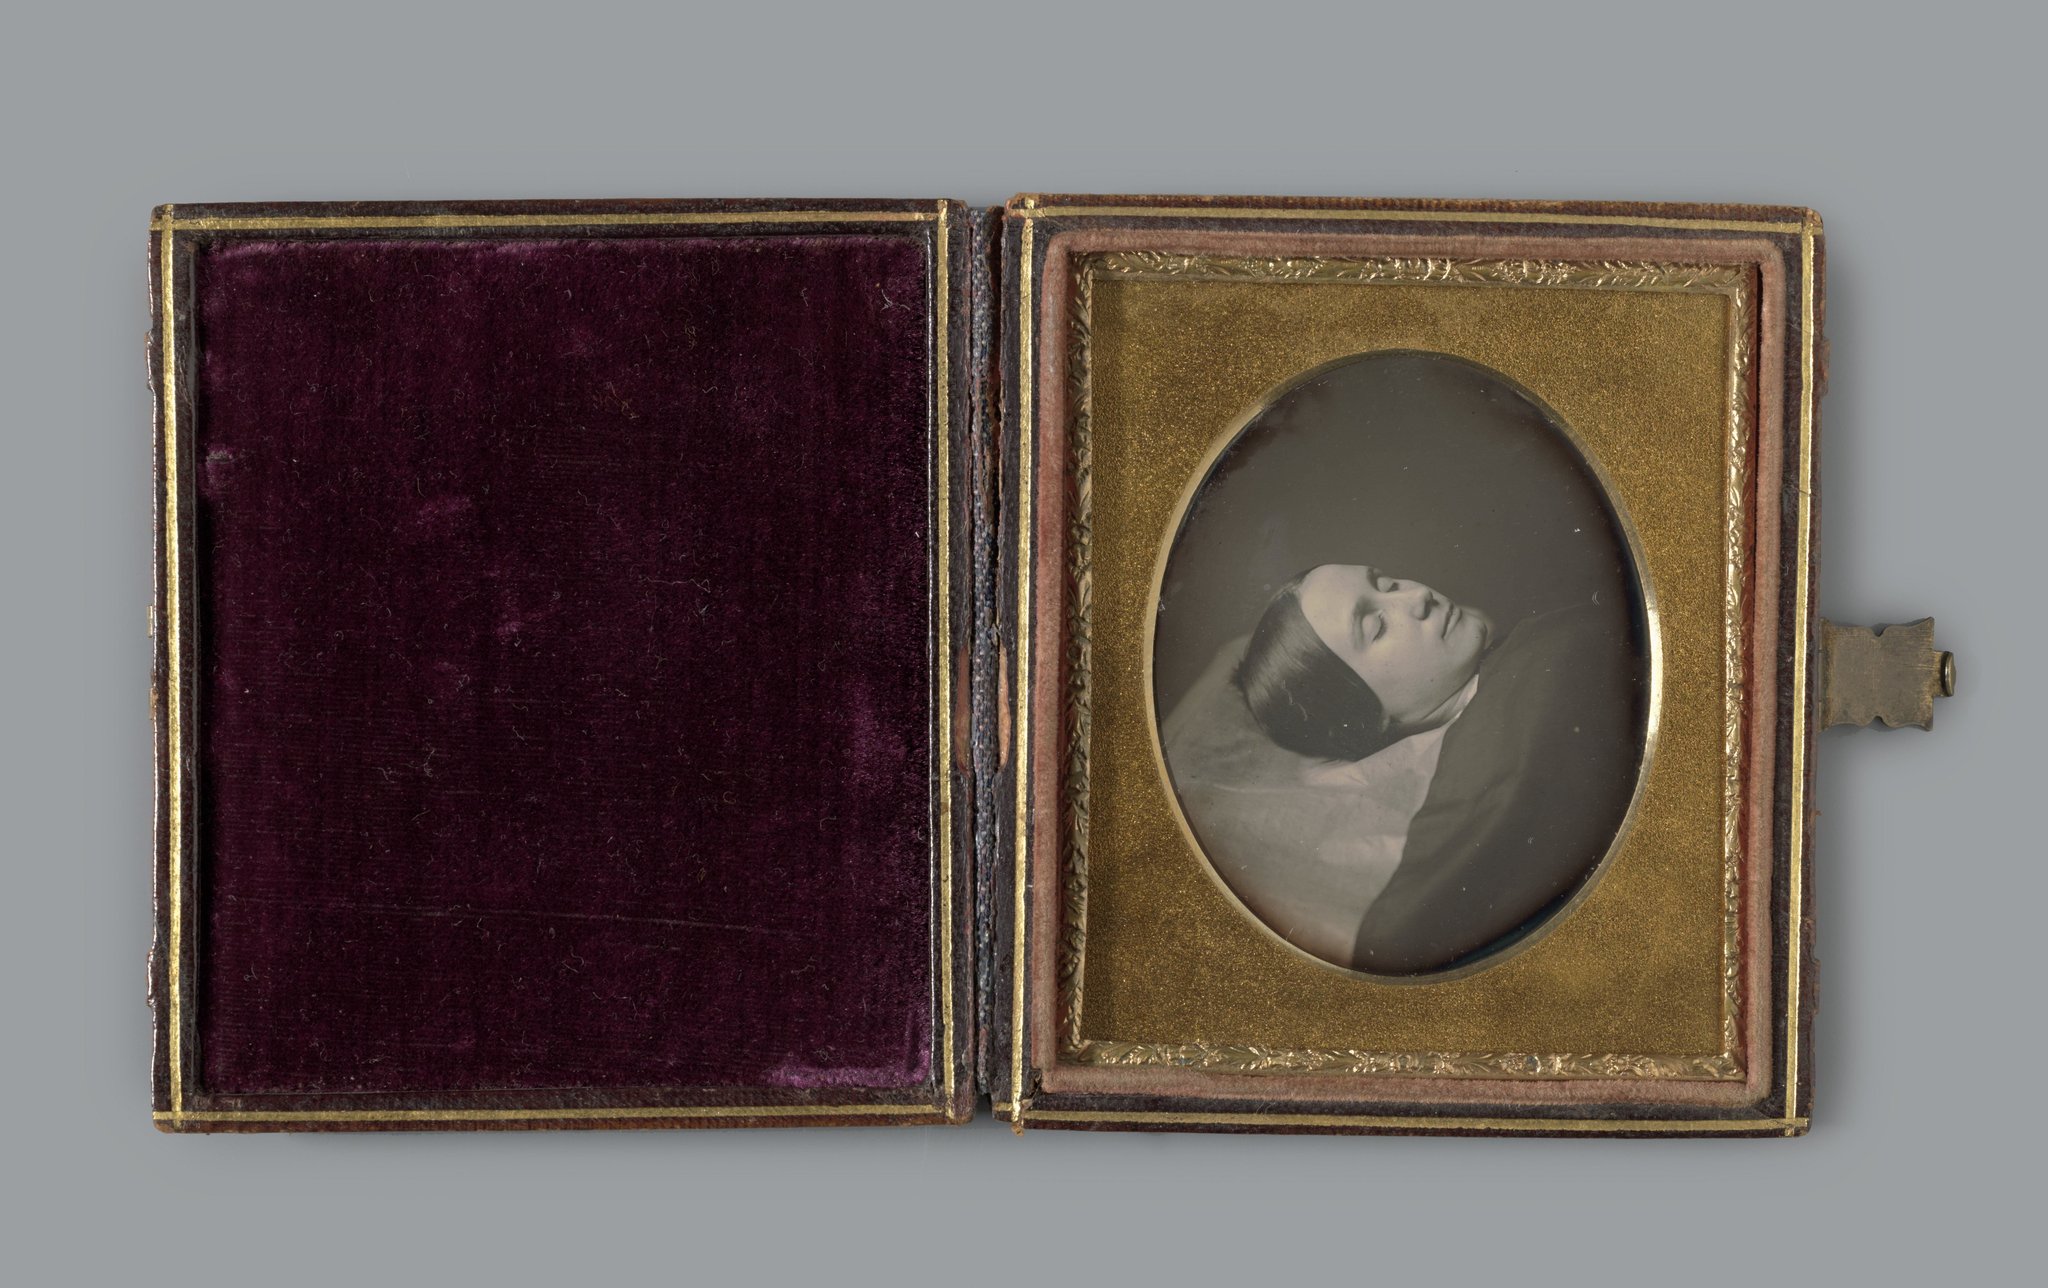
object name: cassette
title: Post-mortem Portrait of a Woman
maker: Anonymous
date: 1845-1855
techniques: daguerreotype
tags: historical persons not known by name - bb - woman, historical persons not known by name - bb - woman (+ death-portrait)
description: The practice of post-mortem photography in the 19th-century was a way of immortalizing the deceased on their deathbed. It kept a beloved dead person close by for a while longer. Particularly daguerreotypy, also known as mirror with a memory, yielded an almost tangible likeness. The little case was opened and the loved one was still there, nearby, and almost touchable.